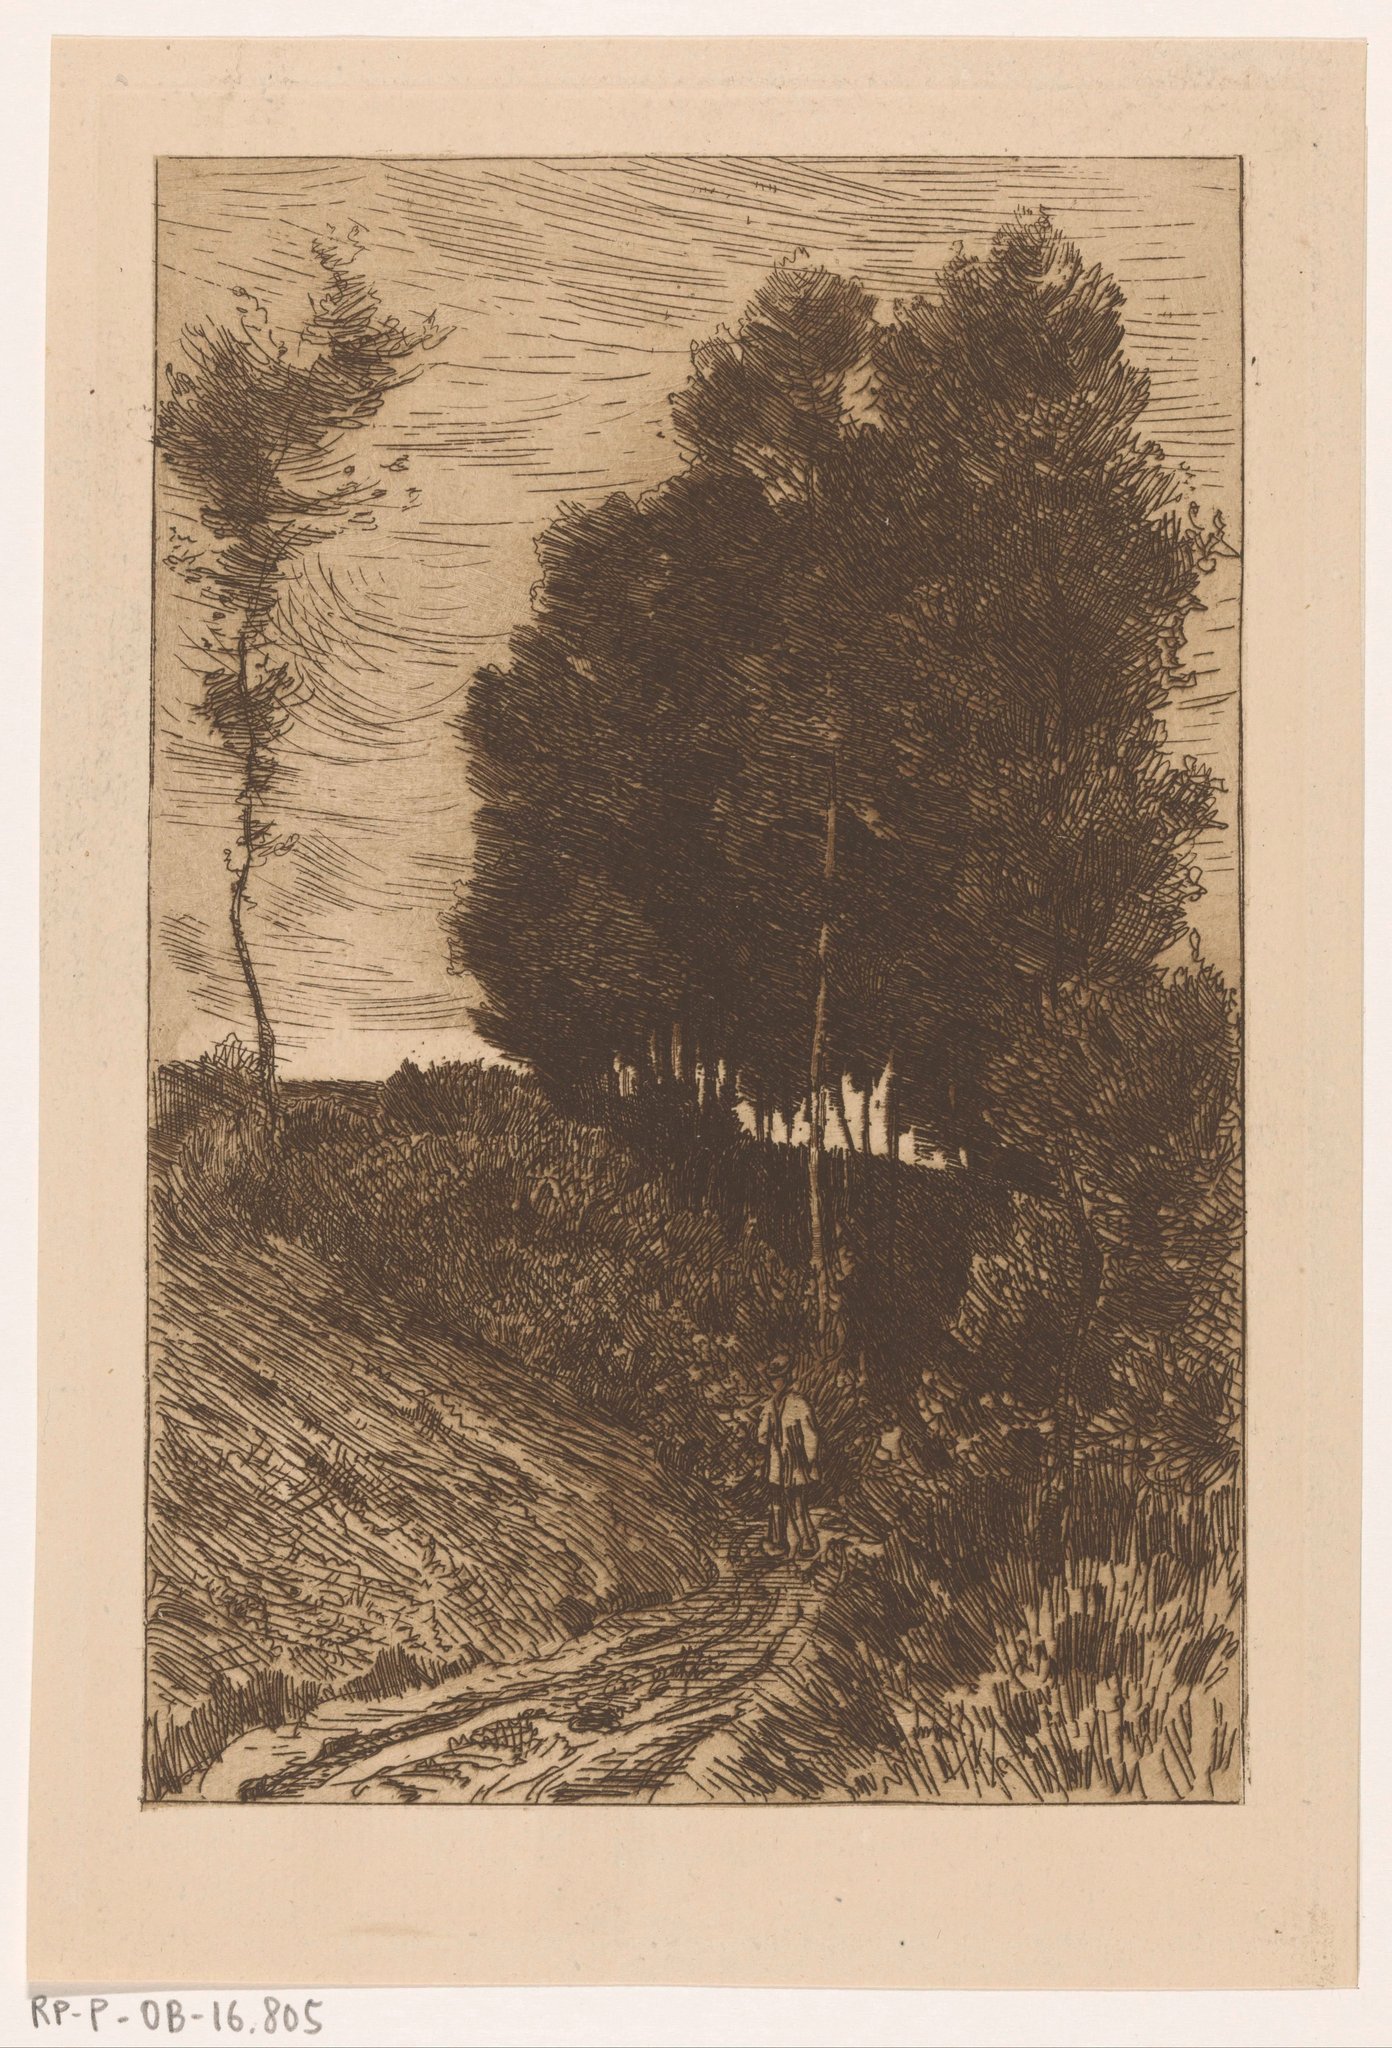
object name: print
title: Figuur op een holle weg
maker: anton l. koster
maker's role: draughtsman, painter, print maker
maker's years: 1859-1937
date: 1869-1937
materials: paper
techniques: etching, intaglio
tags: trees, road, path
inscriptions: collector's mark: Lugt 2228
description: De weg is aan weerszijden begroeid met struiken en bomen.